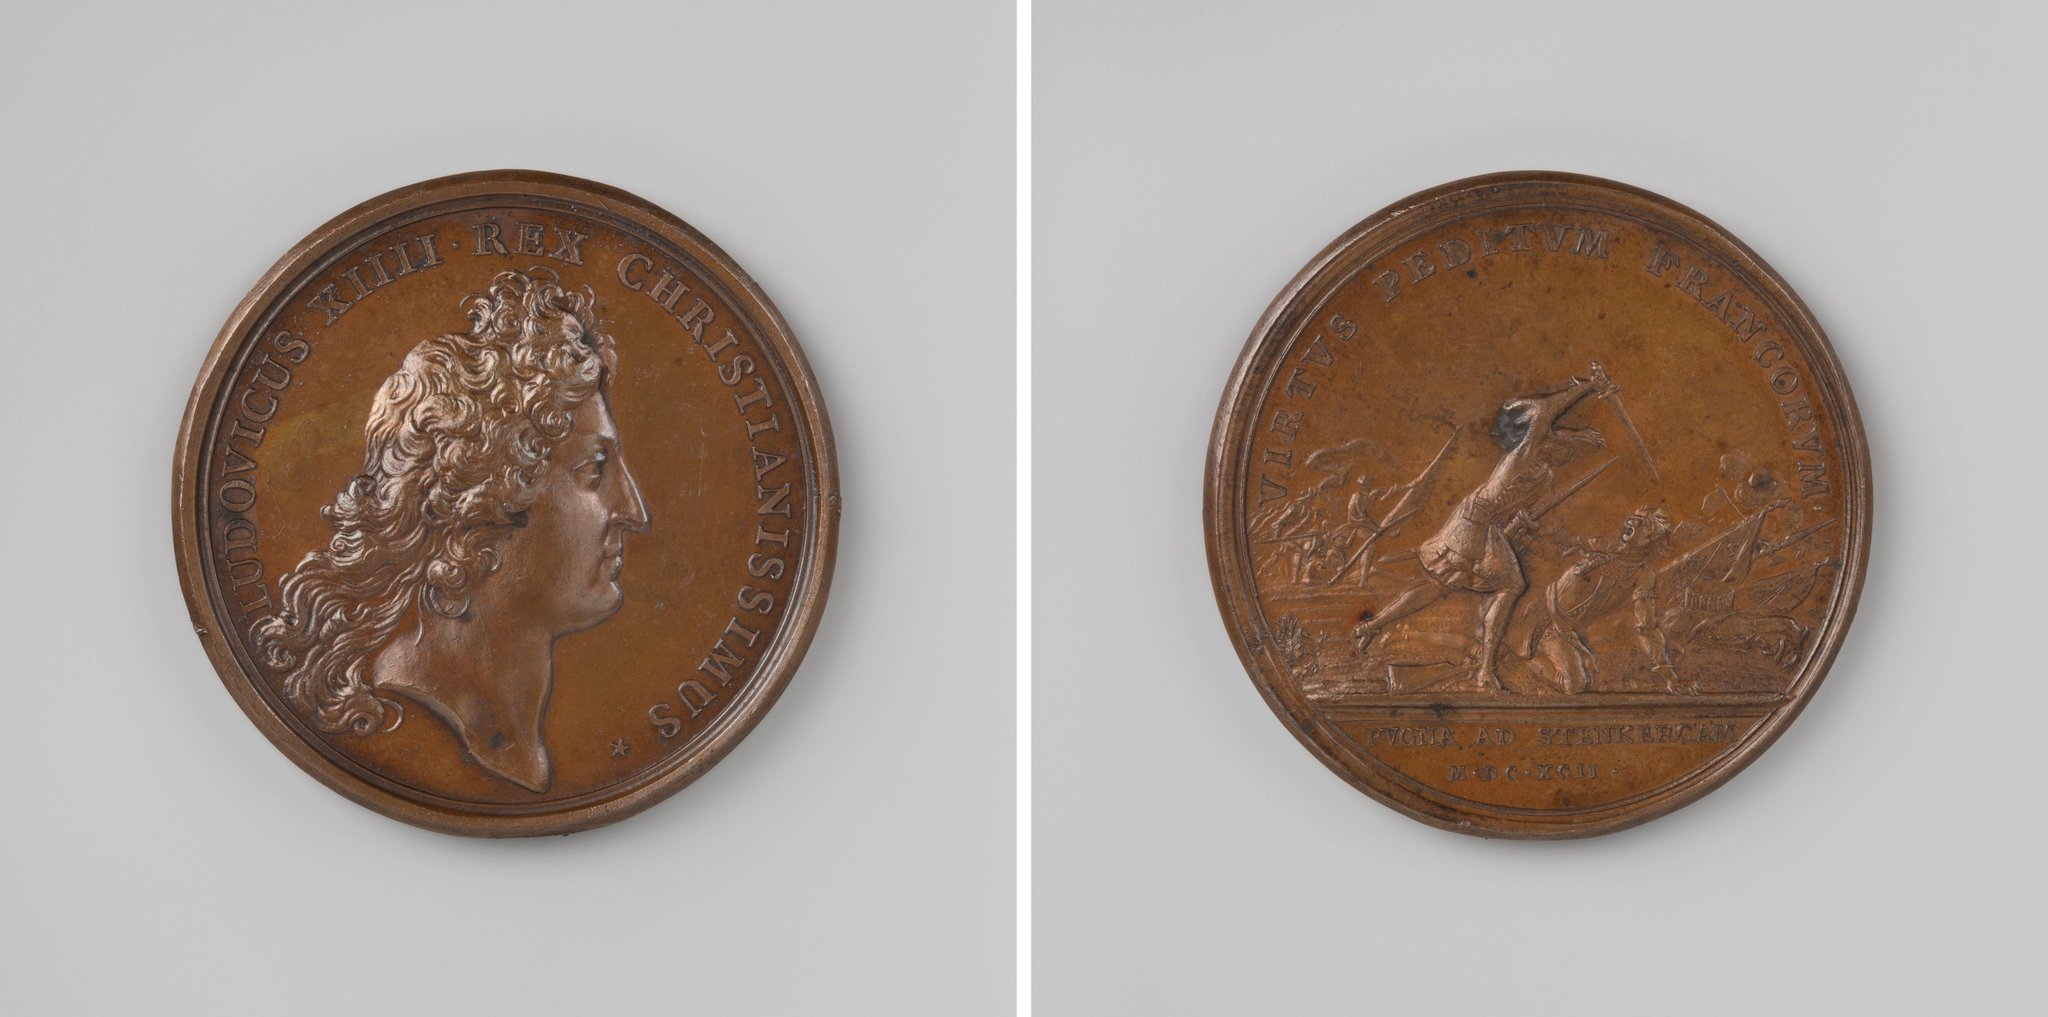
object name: history medal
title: Slag bij Steenkerken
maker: Anonymous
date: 1692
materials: bronze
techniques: striking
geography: paris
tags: lodewijk xiv (koning van frankrijk), henegouwen